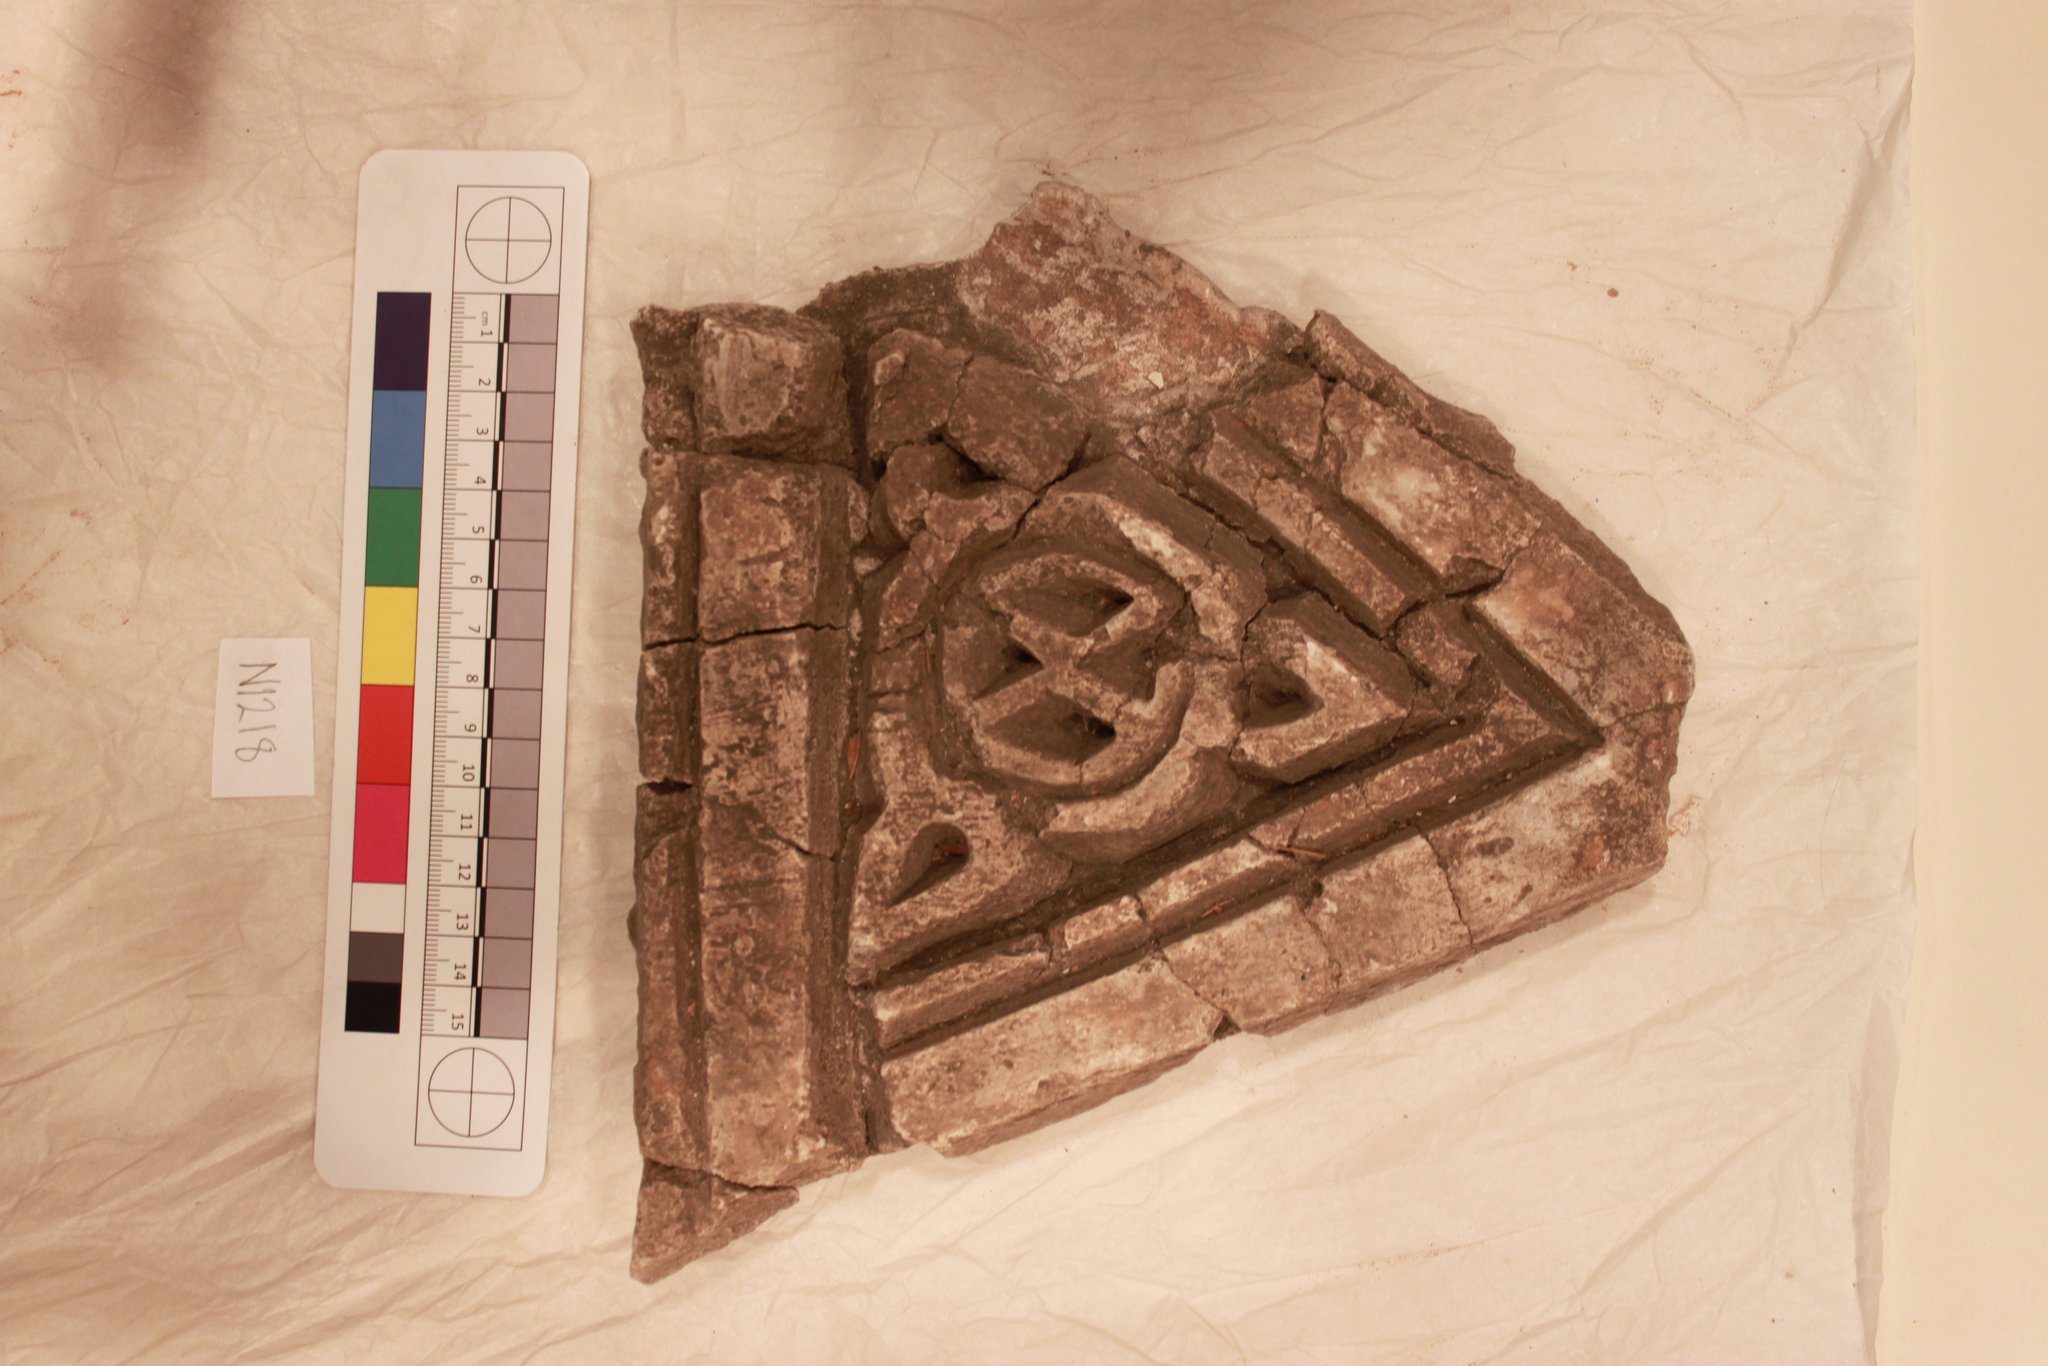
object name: fragment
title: Stucco Fragment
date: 701-1200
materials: plaster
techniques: carving, painting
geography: iran